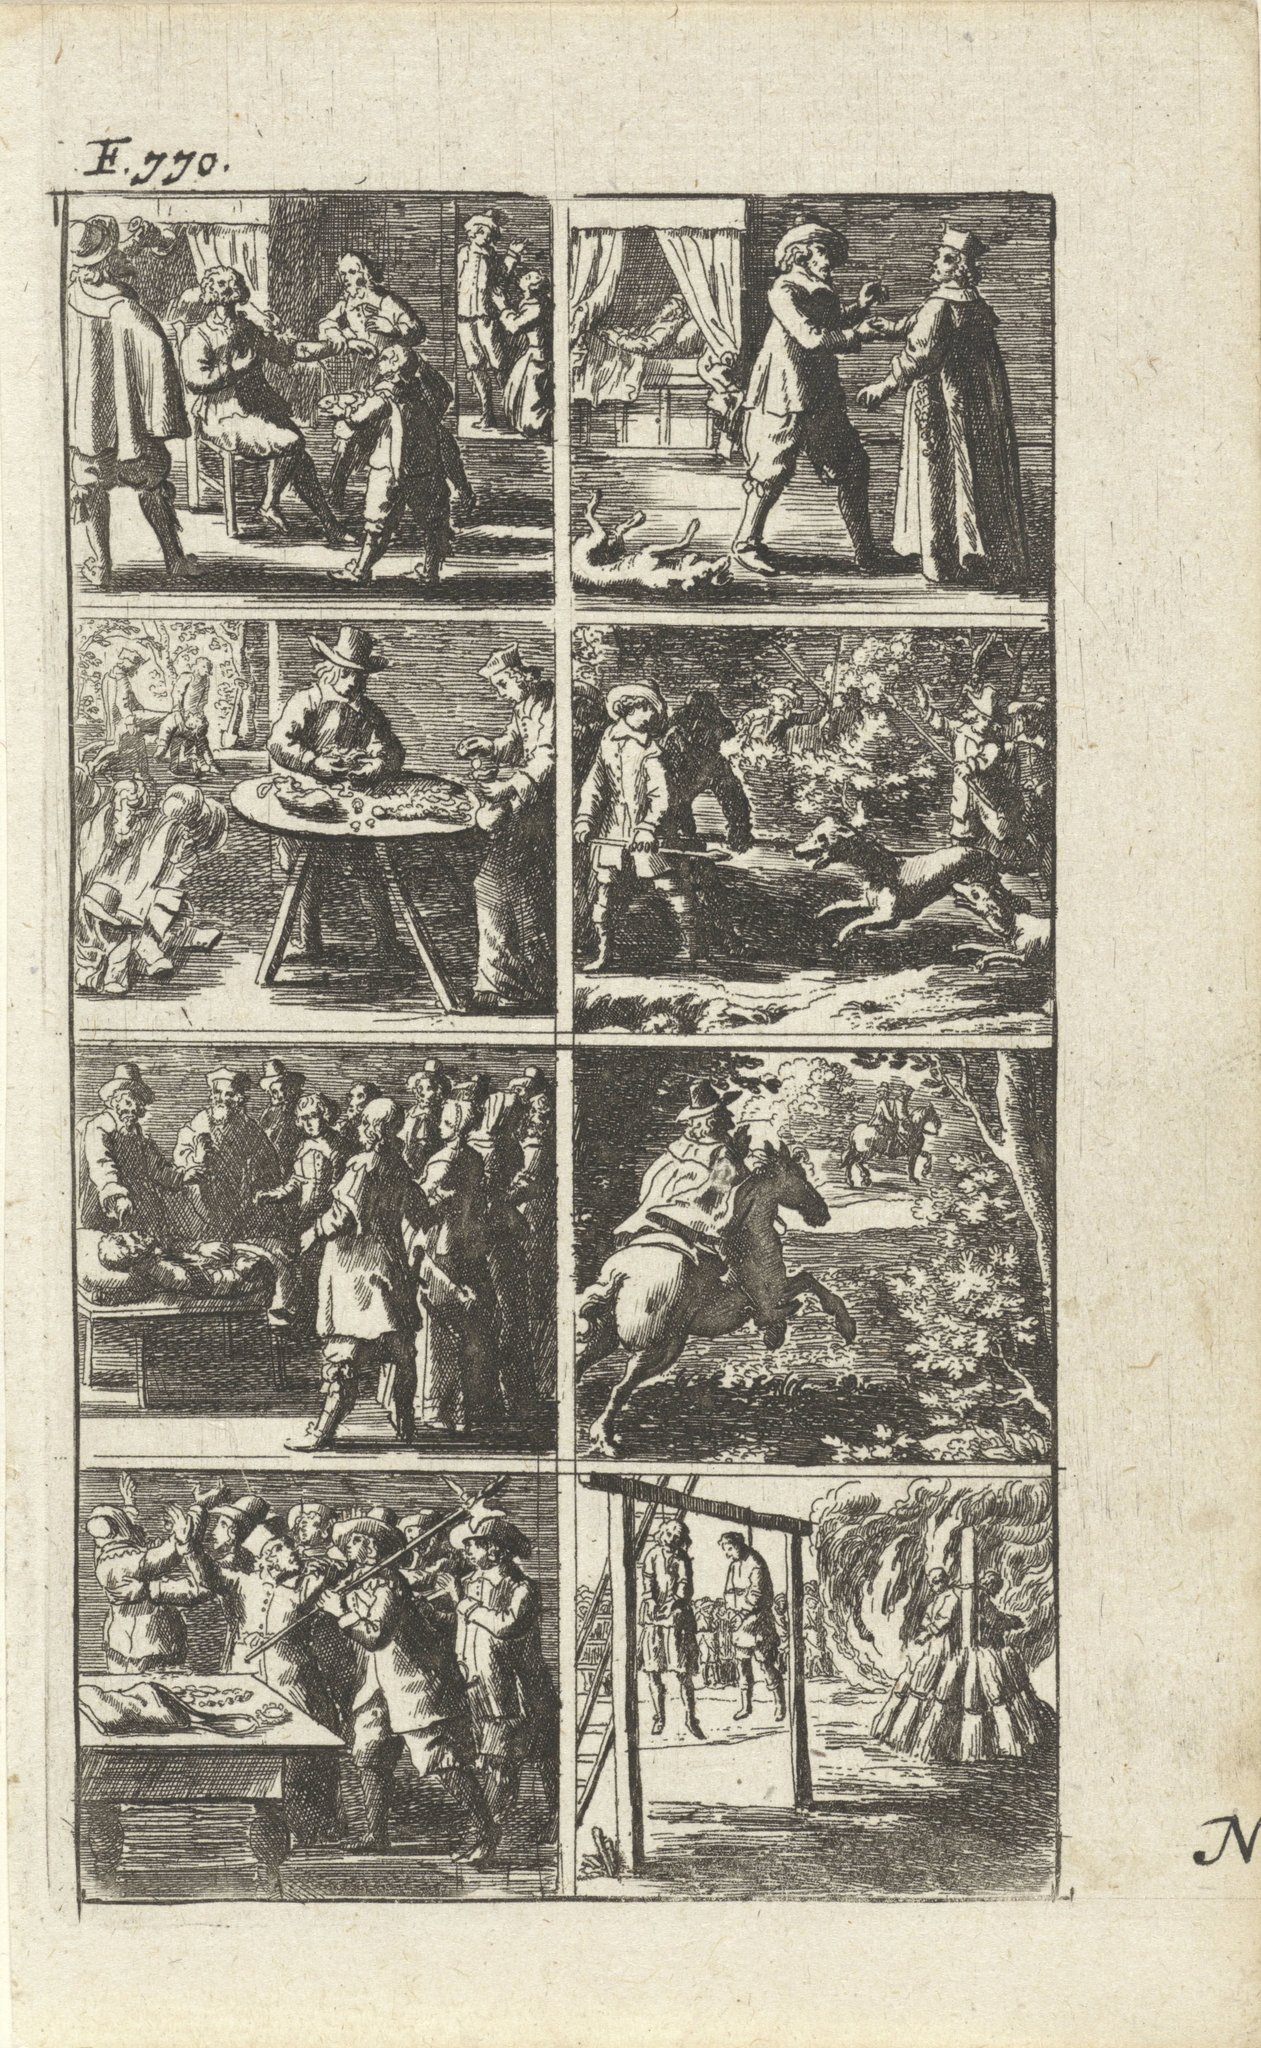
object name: print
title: Verhaal met voorstellingen van moord en doodstraf (F. 770.)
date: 1667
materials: paper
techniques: etching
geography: netherlands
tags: death penalty, execution, murder, fighting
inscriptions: collector's mark: Lugt 2760, collector's mark: Lugt 2166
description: Verhaal in acht scènes met enkele voorstellingen van moord en doodstraf. Rechtsboven twee mannen in een slaapkamer. Daaronder mannen met jachthonden in een bos. Rechtsonder twee mannen aan een galg en twee mannen op een brandstapel. Linksboven: F. 770. Rechtsonder: N.